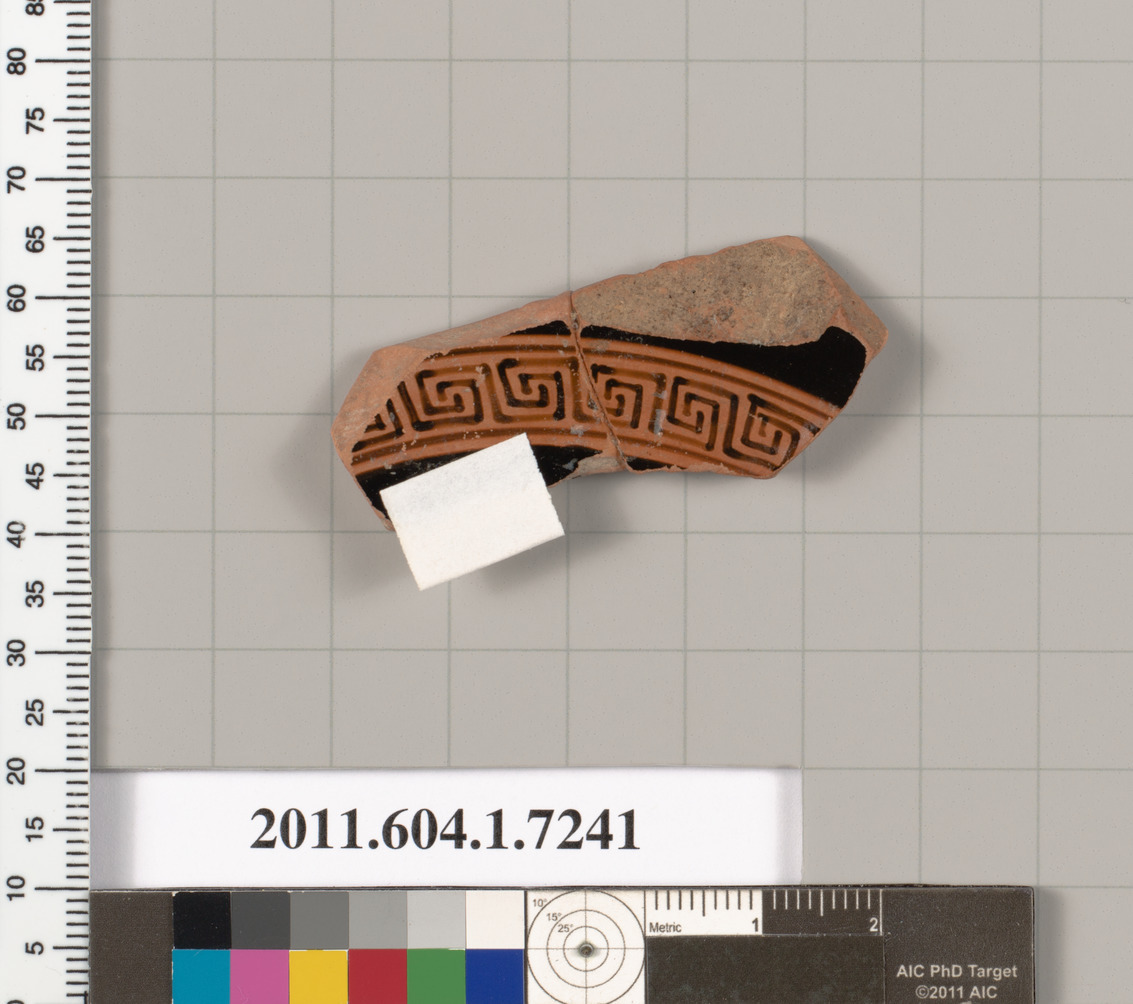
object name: kylix fragment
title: Terracotta fragment of a kylix (drinking cup)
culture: greek, attic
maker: makron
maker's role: artist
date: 500-480 BCE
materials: terracotta